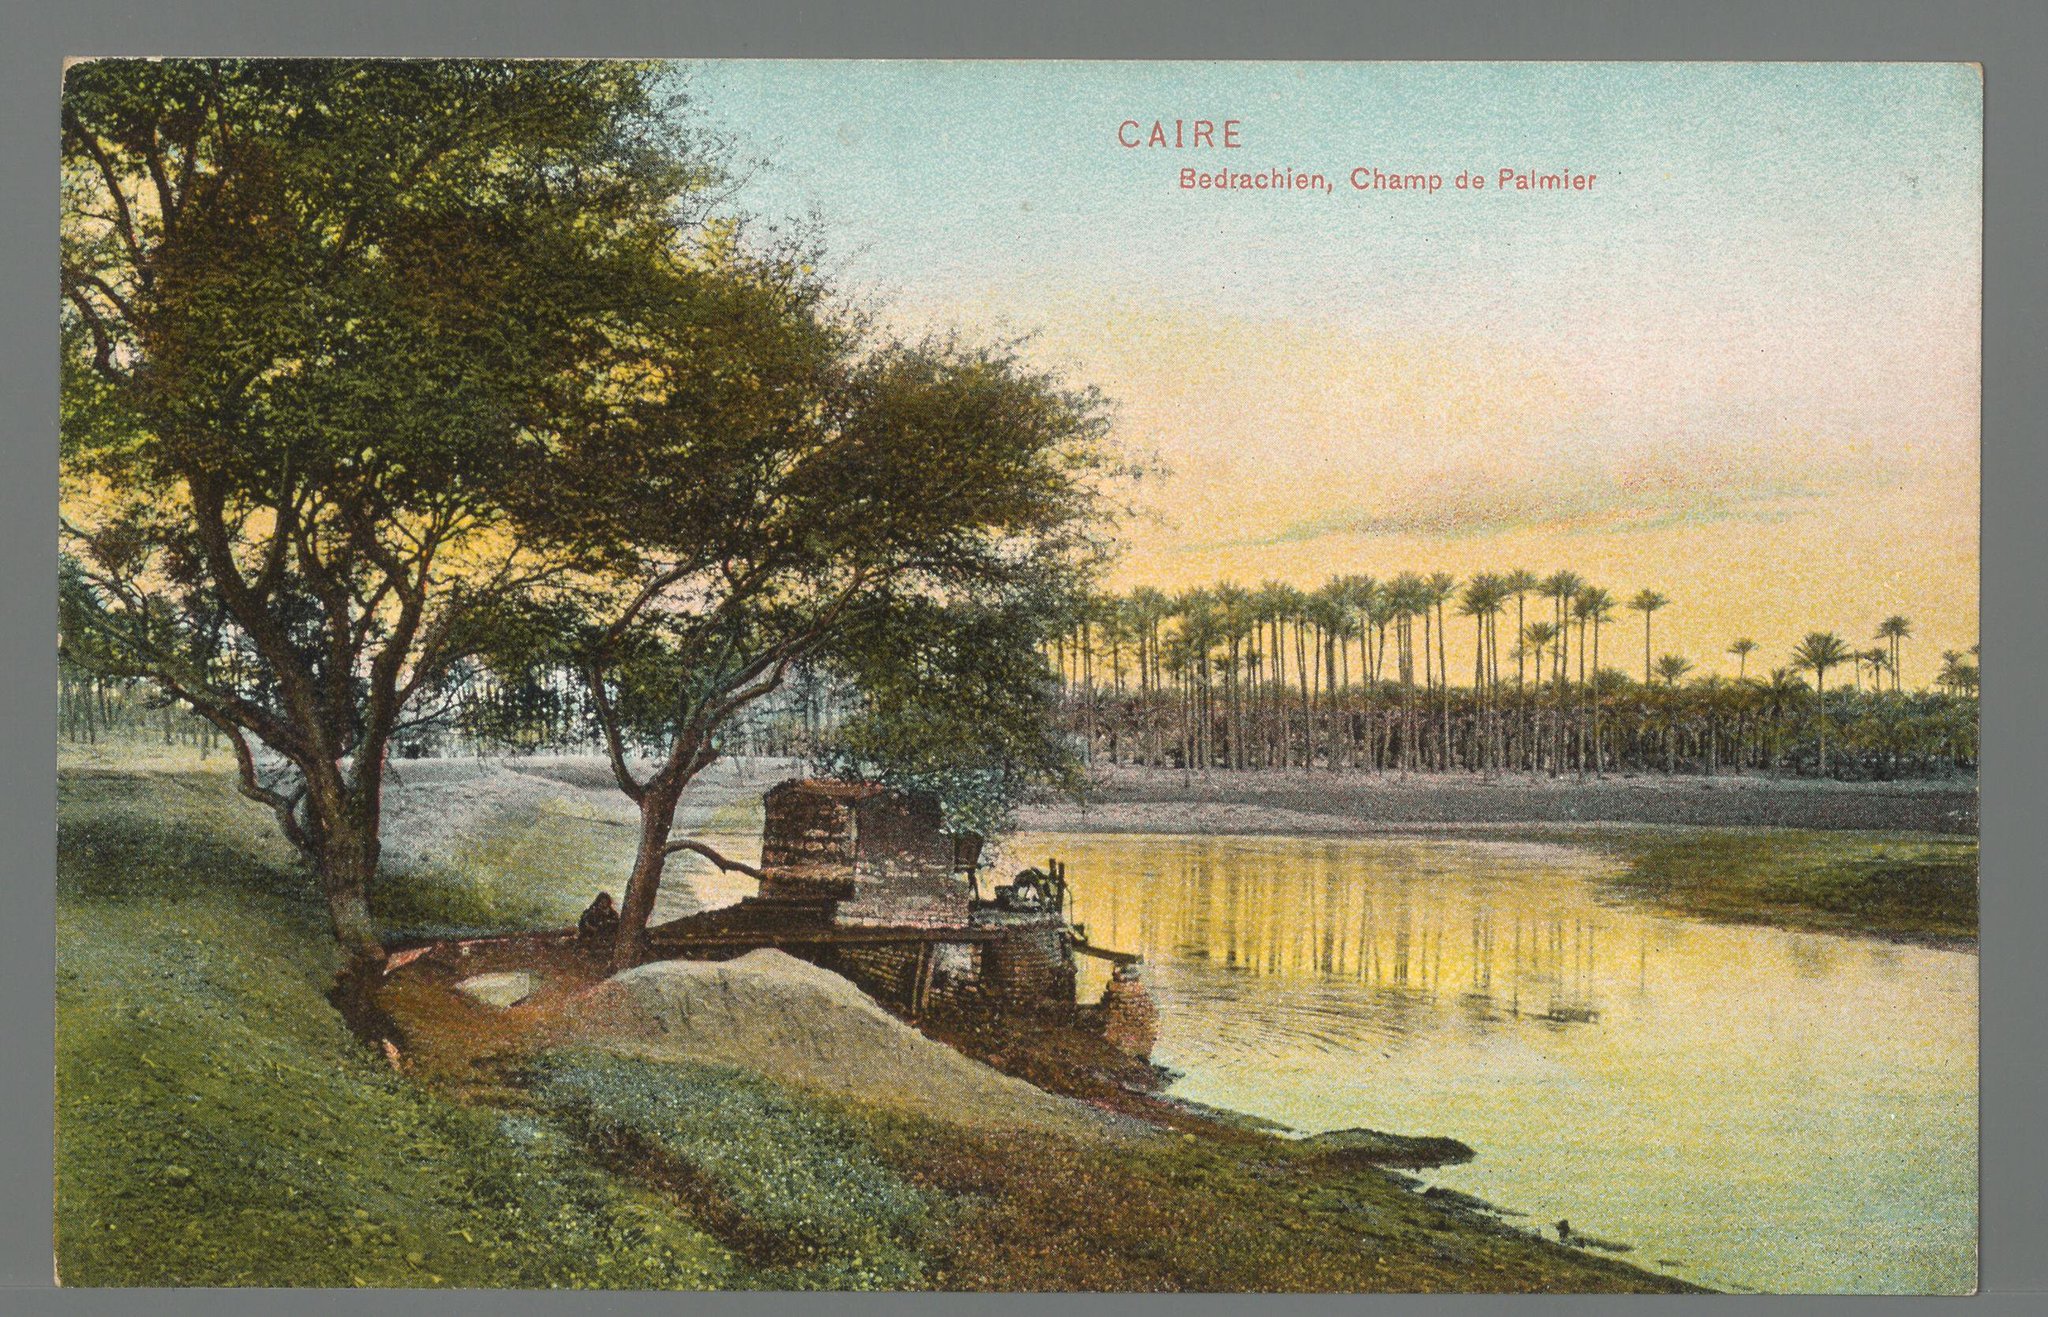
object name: ansichtkaart, prentbriefkaart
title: Caire. Bedrachien, Champ de Palmier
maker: Anonymous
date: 1907-1930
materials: cardboard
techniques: lithograph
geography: leipzig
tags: river, trees: palm-tree